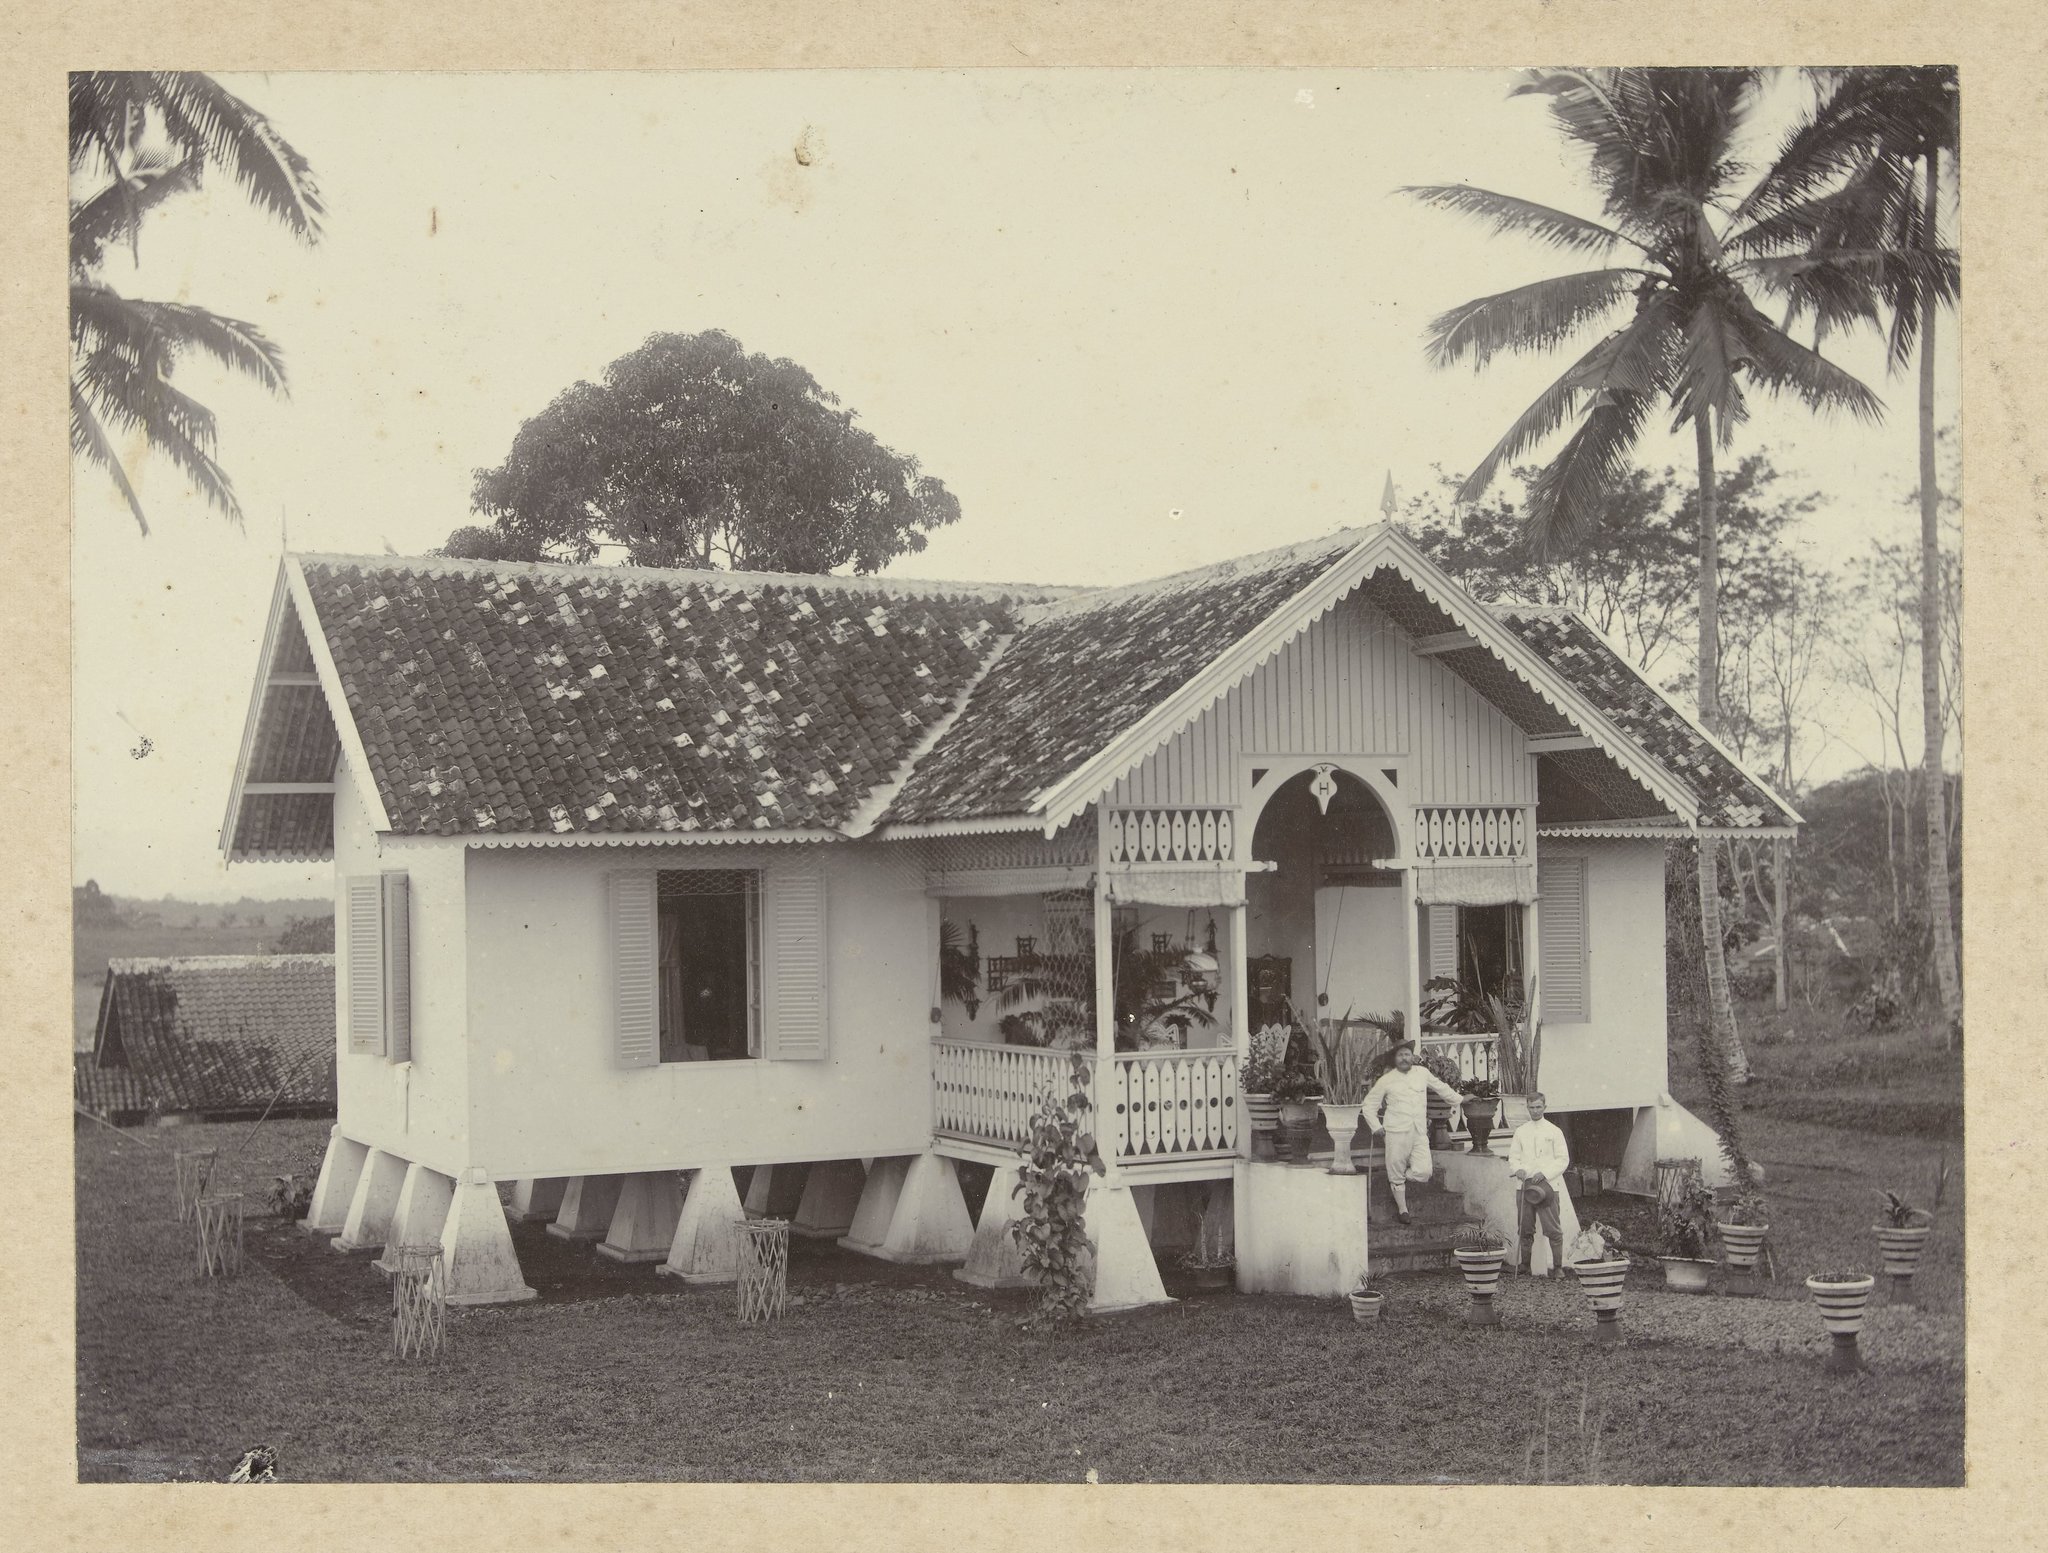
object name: photograph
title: Twee mannen voor de veranda van een huis in Nederlands-Indië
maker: Anonymous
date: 1895-1920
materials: paper, cardboard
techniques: matte daylight collodion silver print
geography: dutch east indies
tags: rural housing, e.g. country-house, villa, cottage, anonymous historical person portrayed, dutch east indies, the